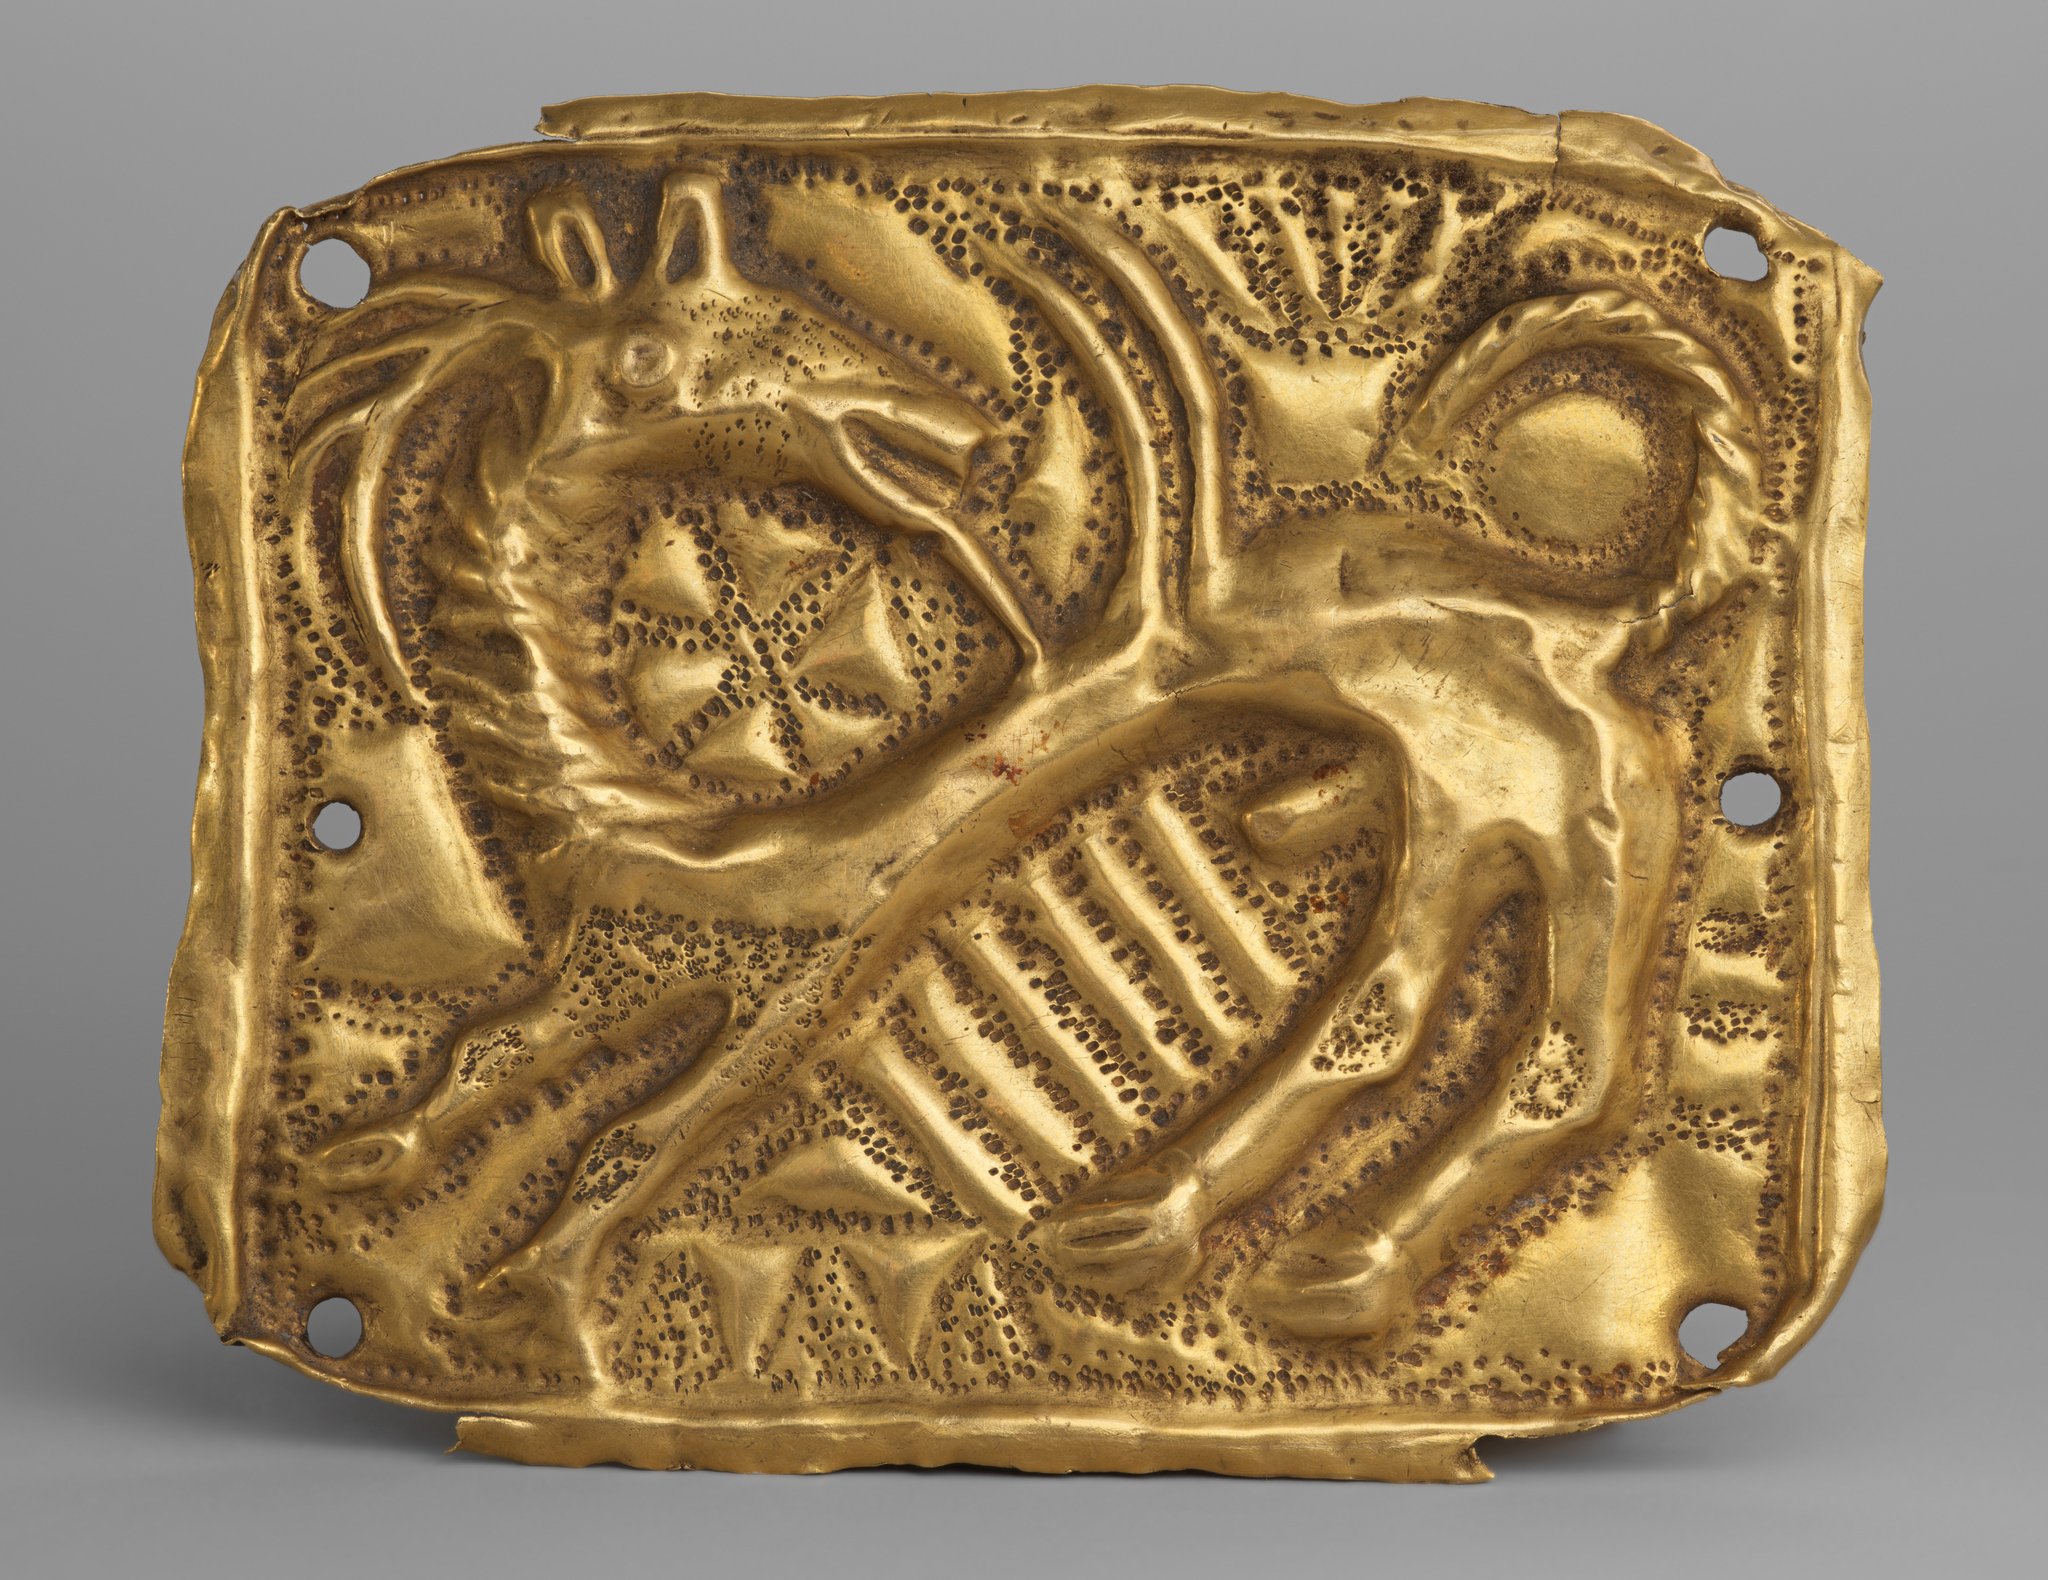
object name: relief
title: Plaque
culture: scytho-sarmatian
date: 500-301 BCE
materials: gold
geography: eurasian steppes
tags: animals